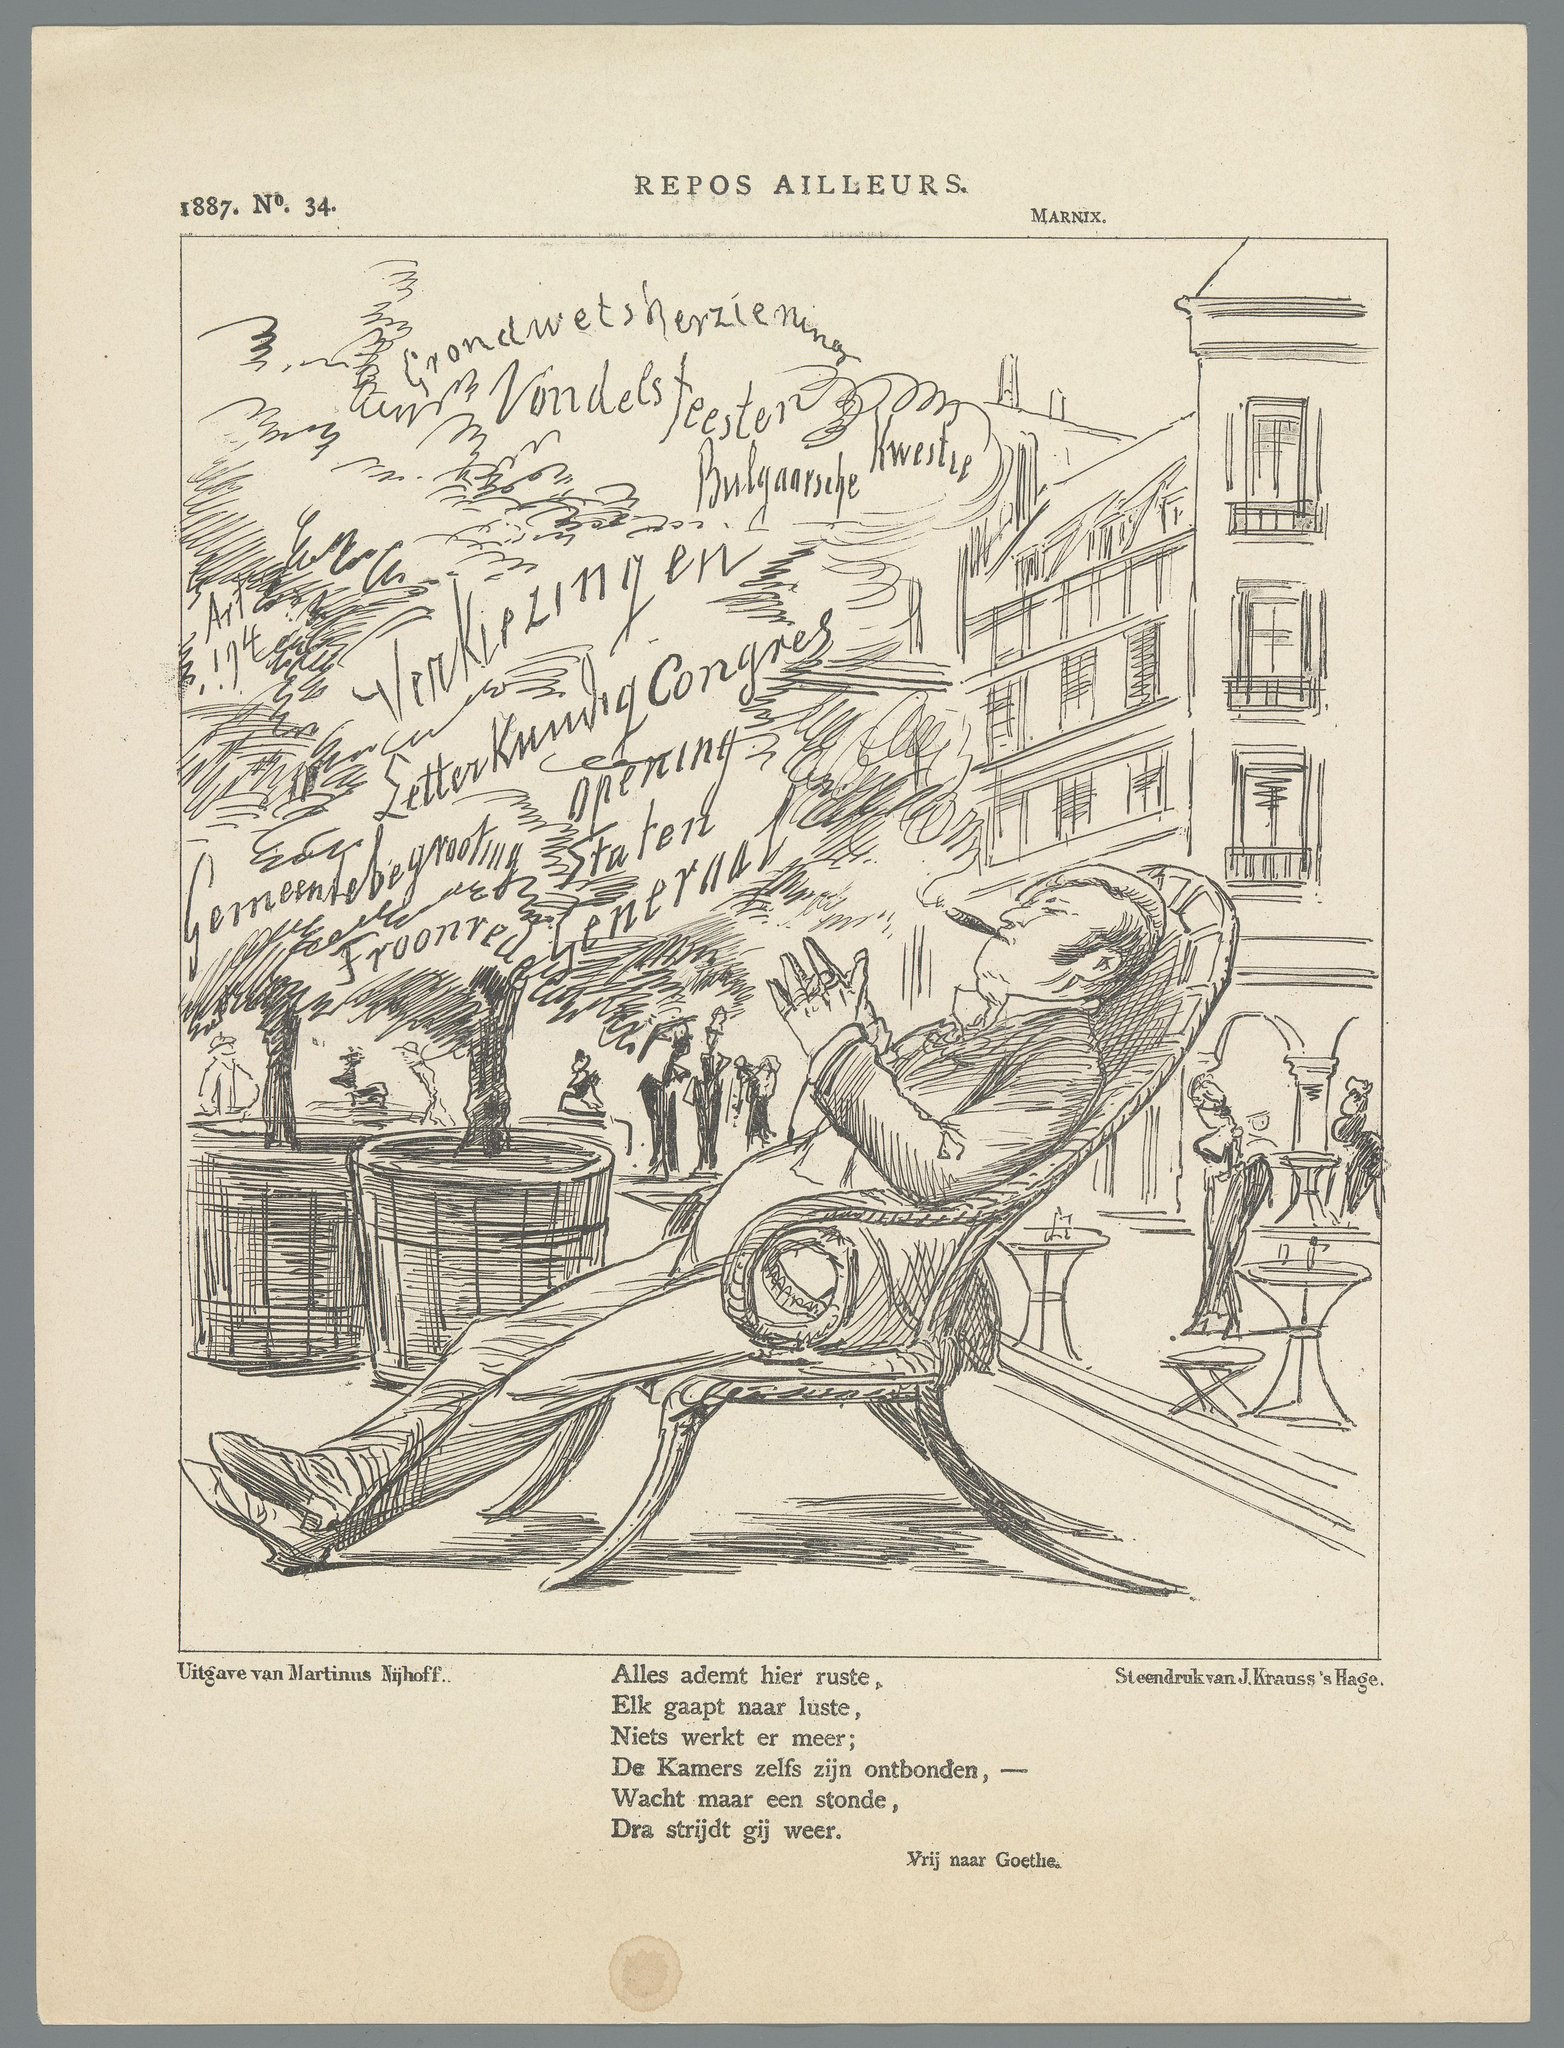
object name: cartoon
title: Repos Ailleurs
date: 1887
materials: paper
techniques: lithograph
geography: the hague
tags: the hague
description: Spotprent over het zomerreces in Den Haag. Plaat verschenen bij het weekblad De Nederlandsche Spectator, nr. 34, 1887.